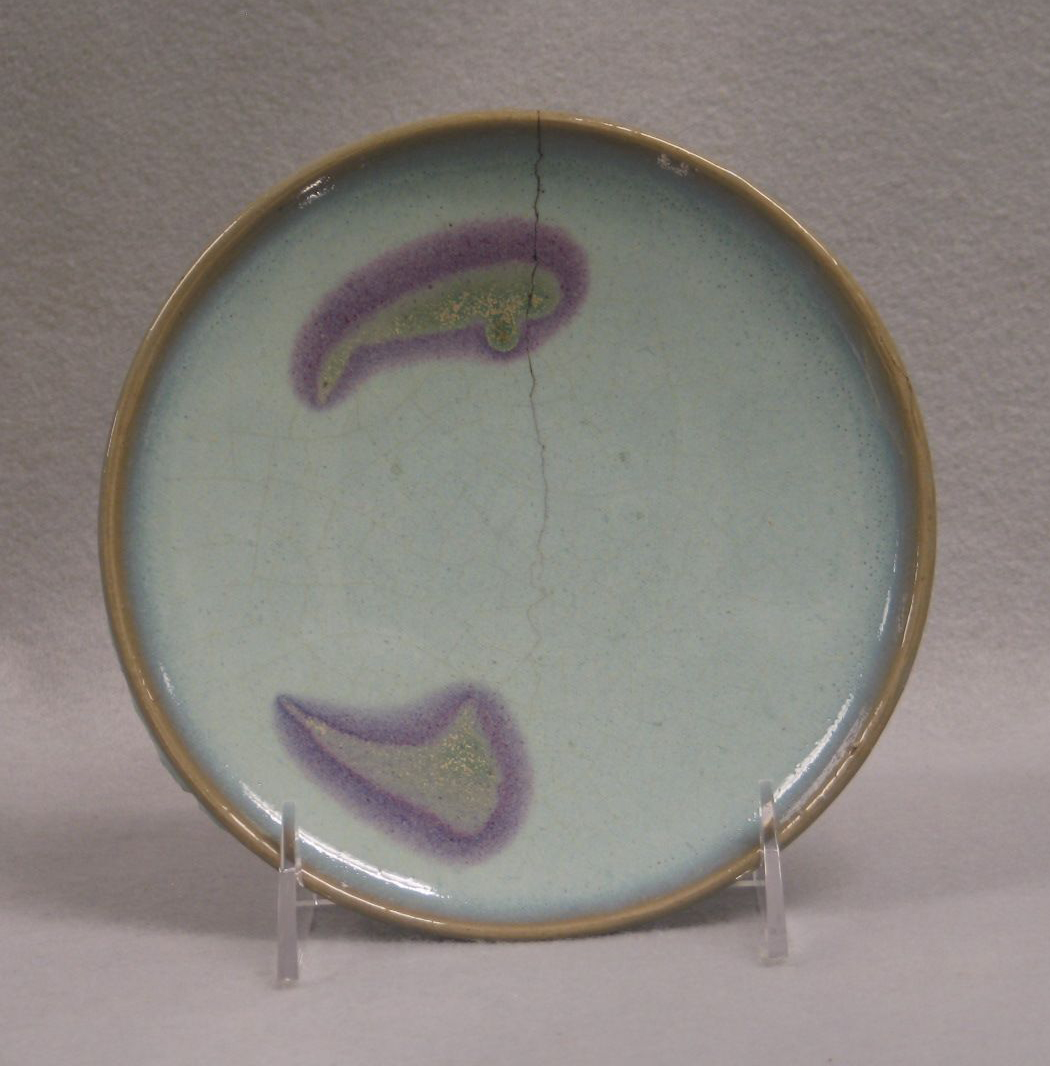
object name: dish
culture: chinese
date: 1101-1300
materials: glaze, stoneware